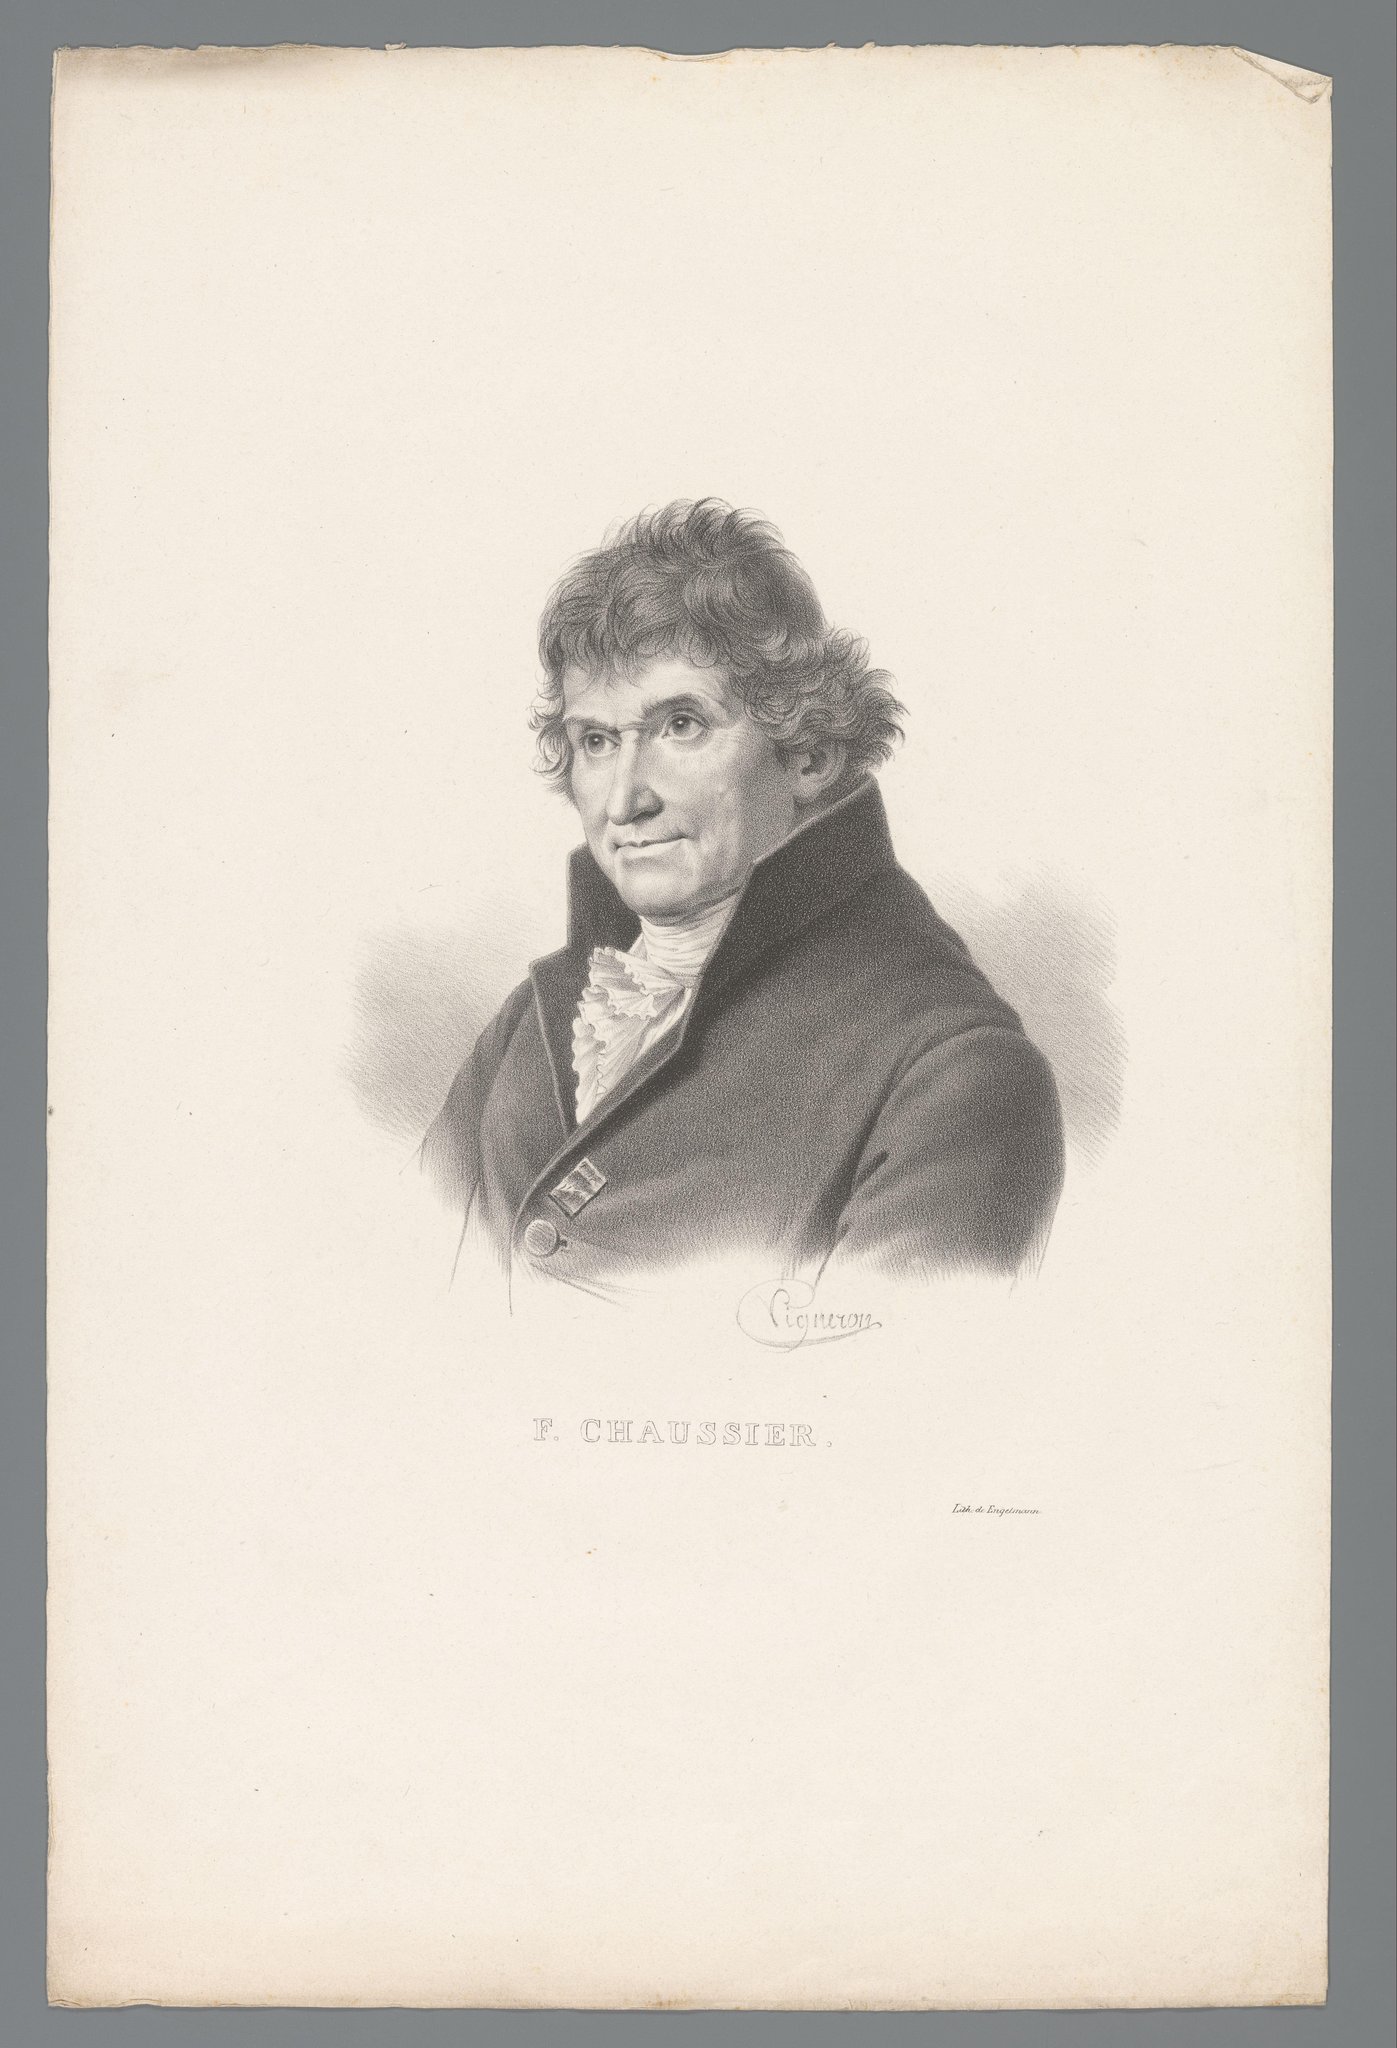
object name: print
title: Portret van François Chaussier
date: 1816-1833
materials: paper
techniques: lithograph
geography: paris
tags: historical persons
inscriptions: collector's mark: Lugt 2228